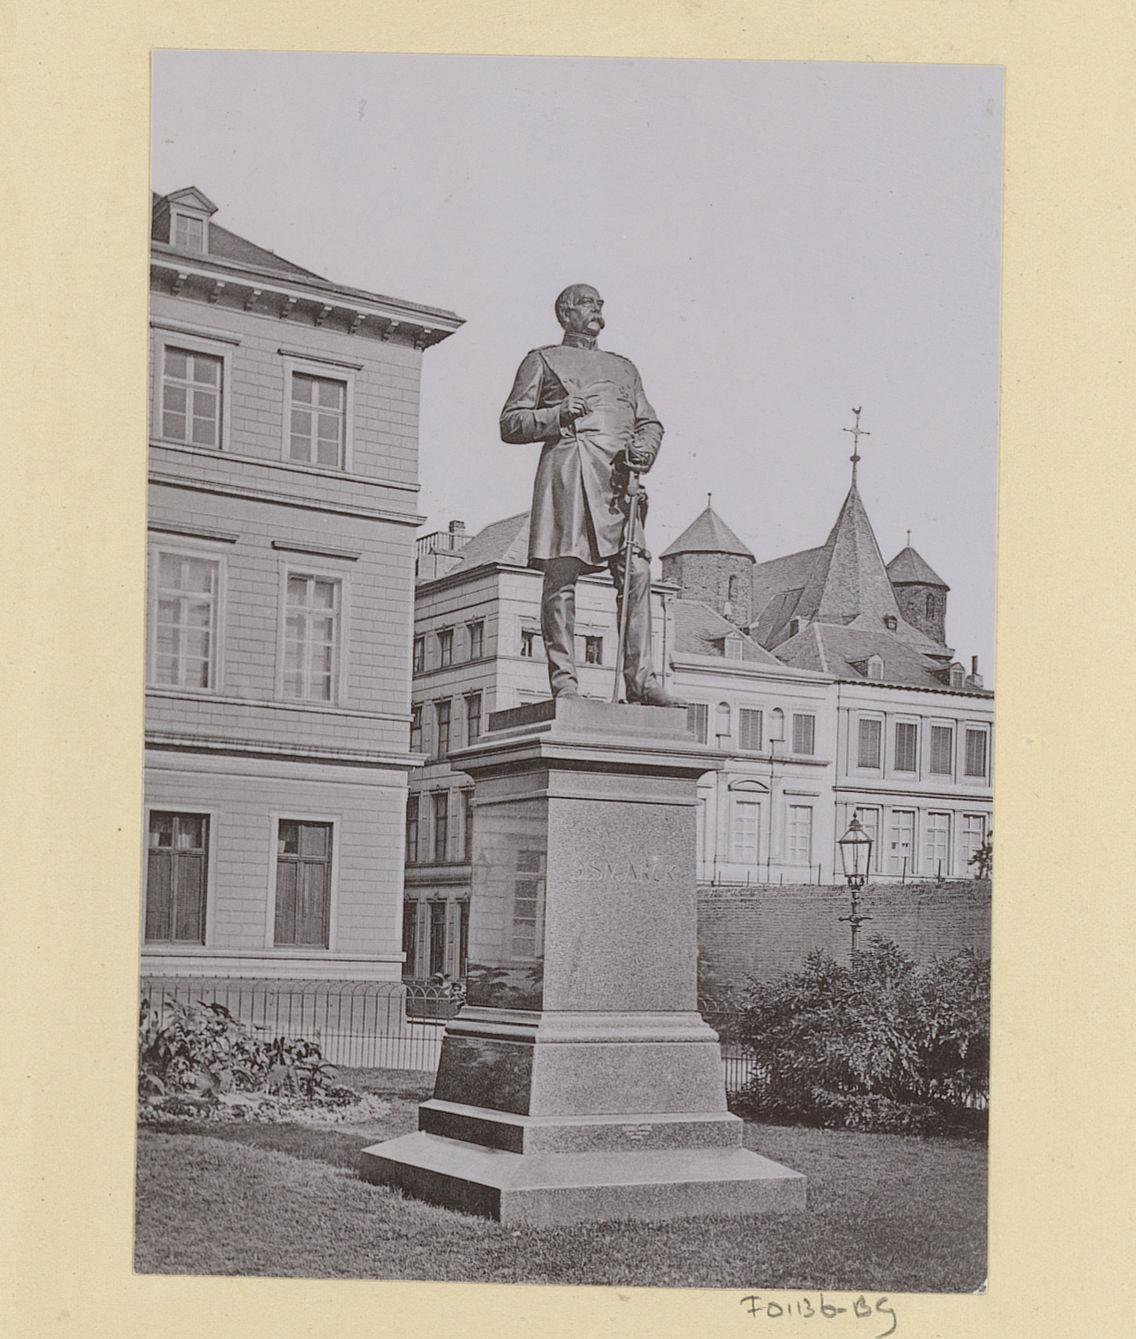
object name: photomechanical print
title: Bismarckmonument op de Augustinerplatz in Keulen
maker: Anonymous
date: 1880-1895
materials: paper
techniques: photograph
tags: monument, statue, cologne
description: Onderdeel van Fotoalbum met opnames van bezienswaardigheden in België, Duitsland en Noorwegen.